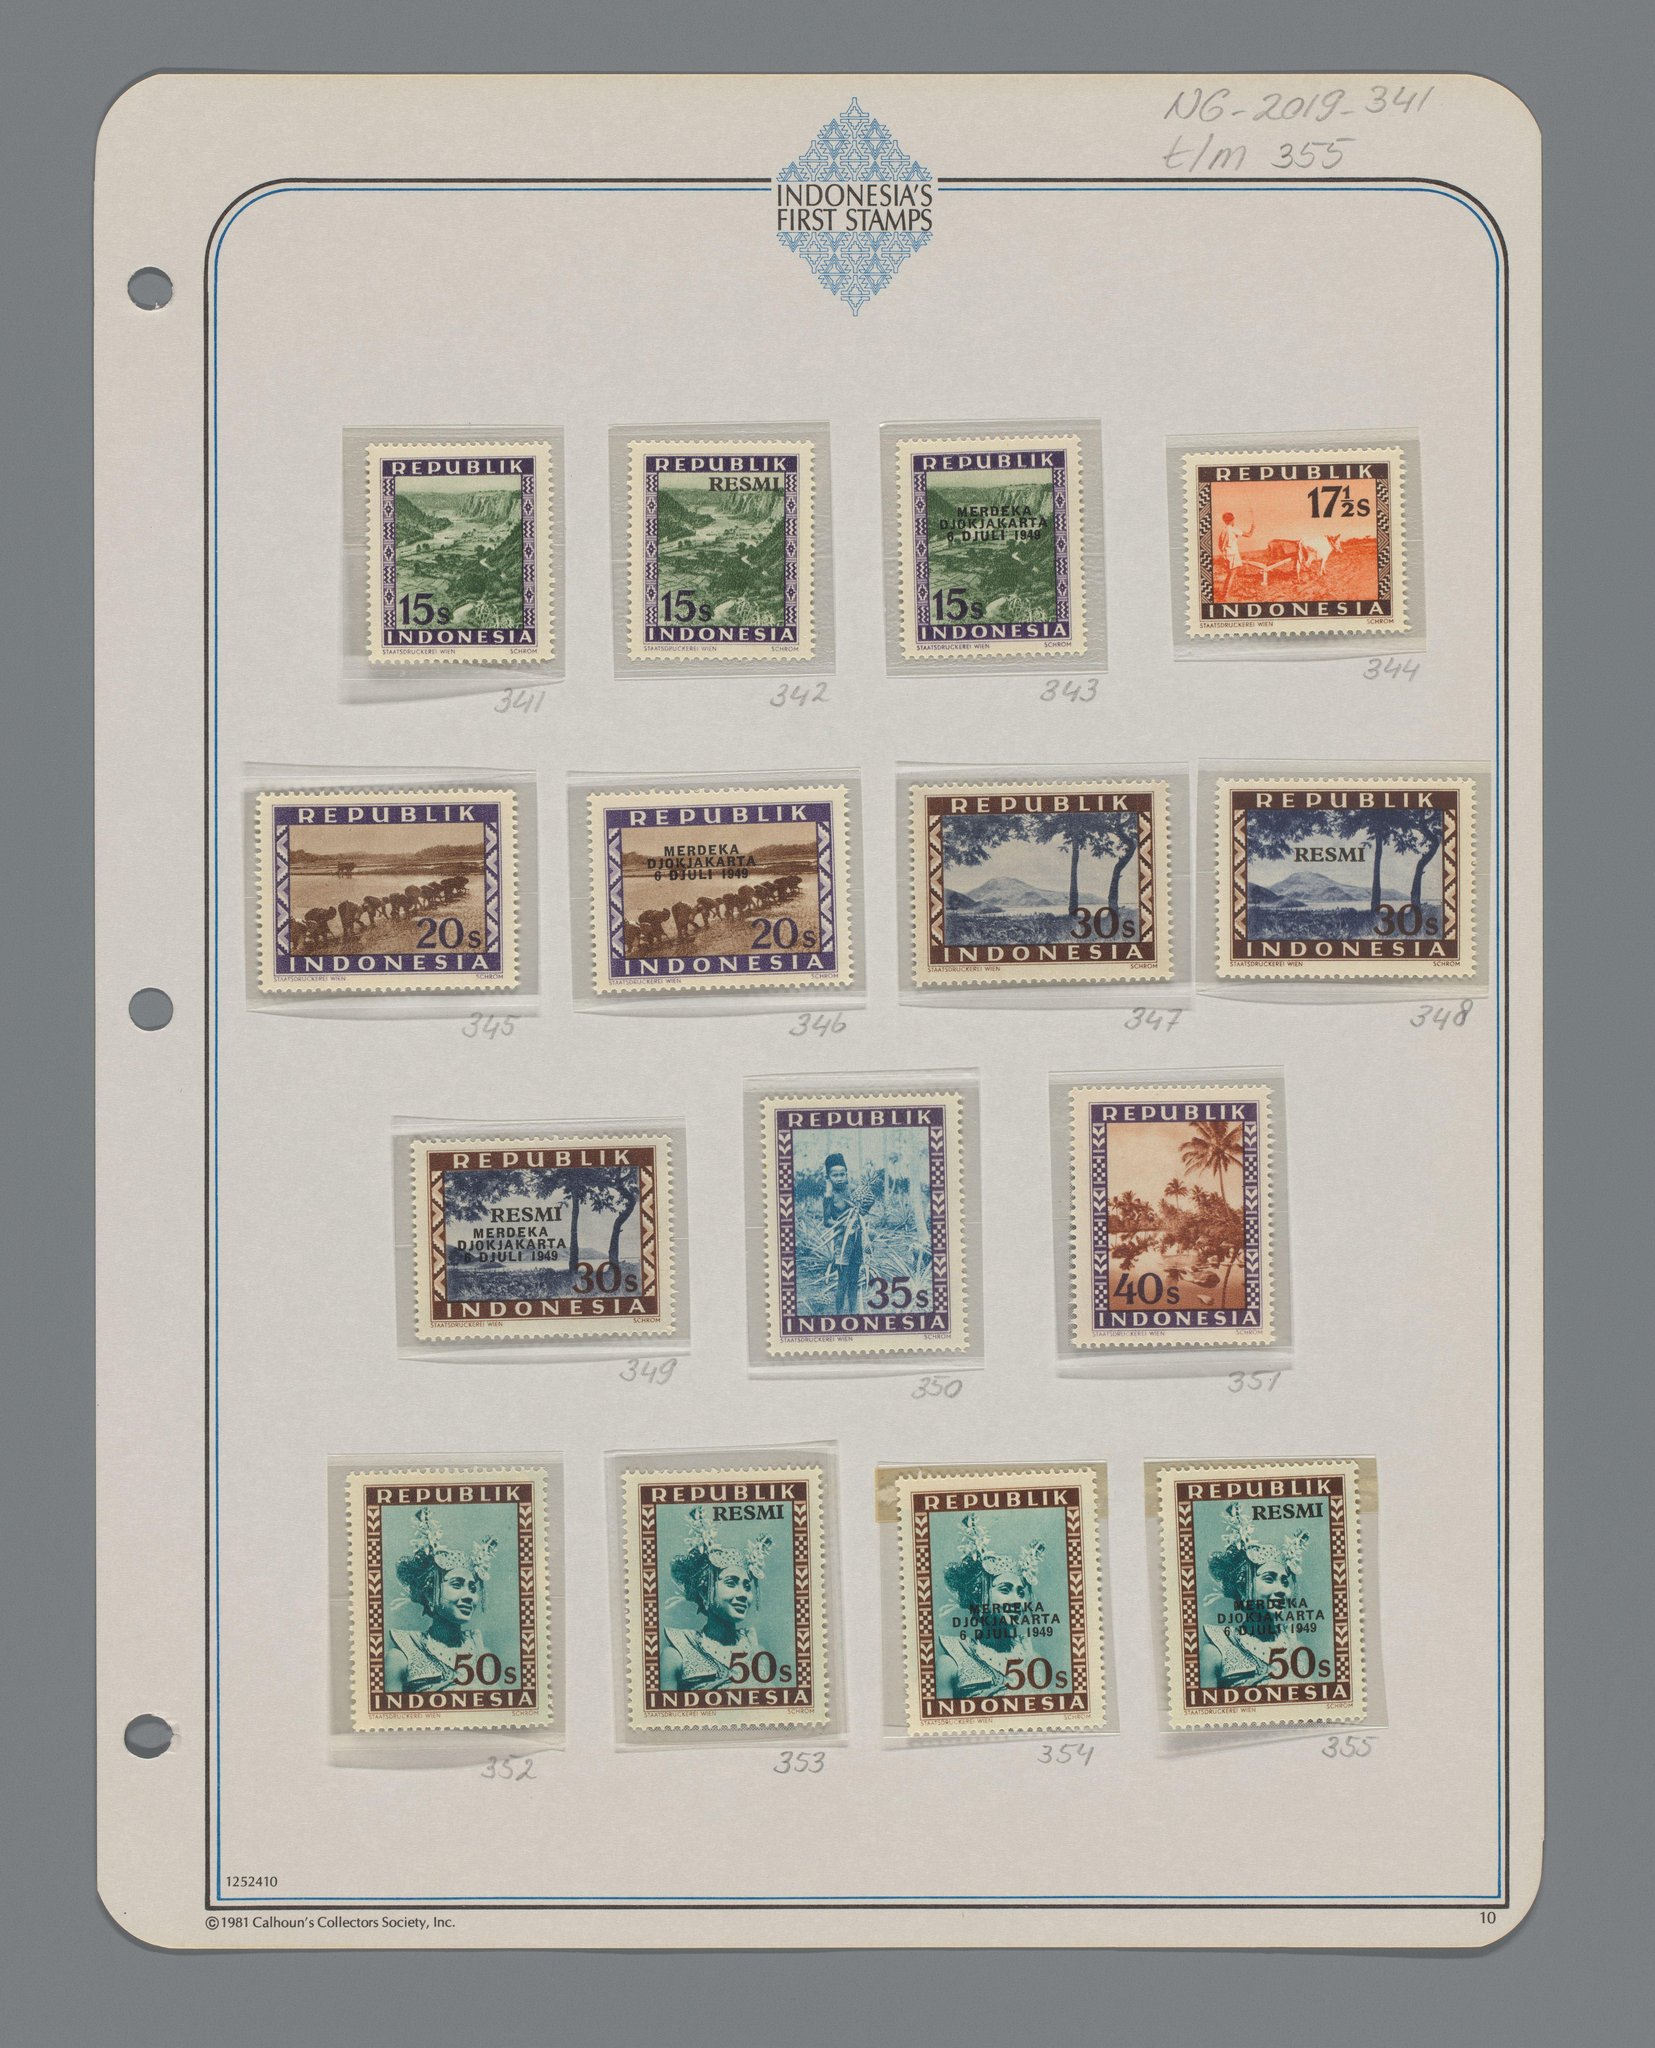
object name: postage stamp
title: Postzegel Republik Indonesia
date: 1949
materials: paper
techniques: photoaquatint, engraving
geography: philadelphia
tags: indonesia